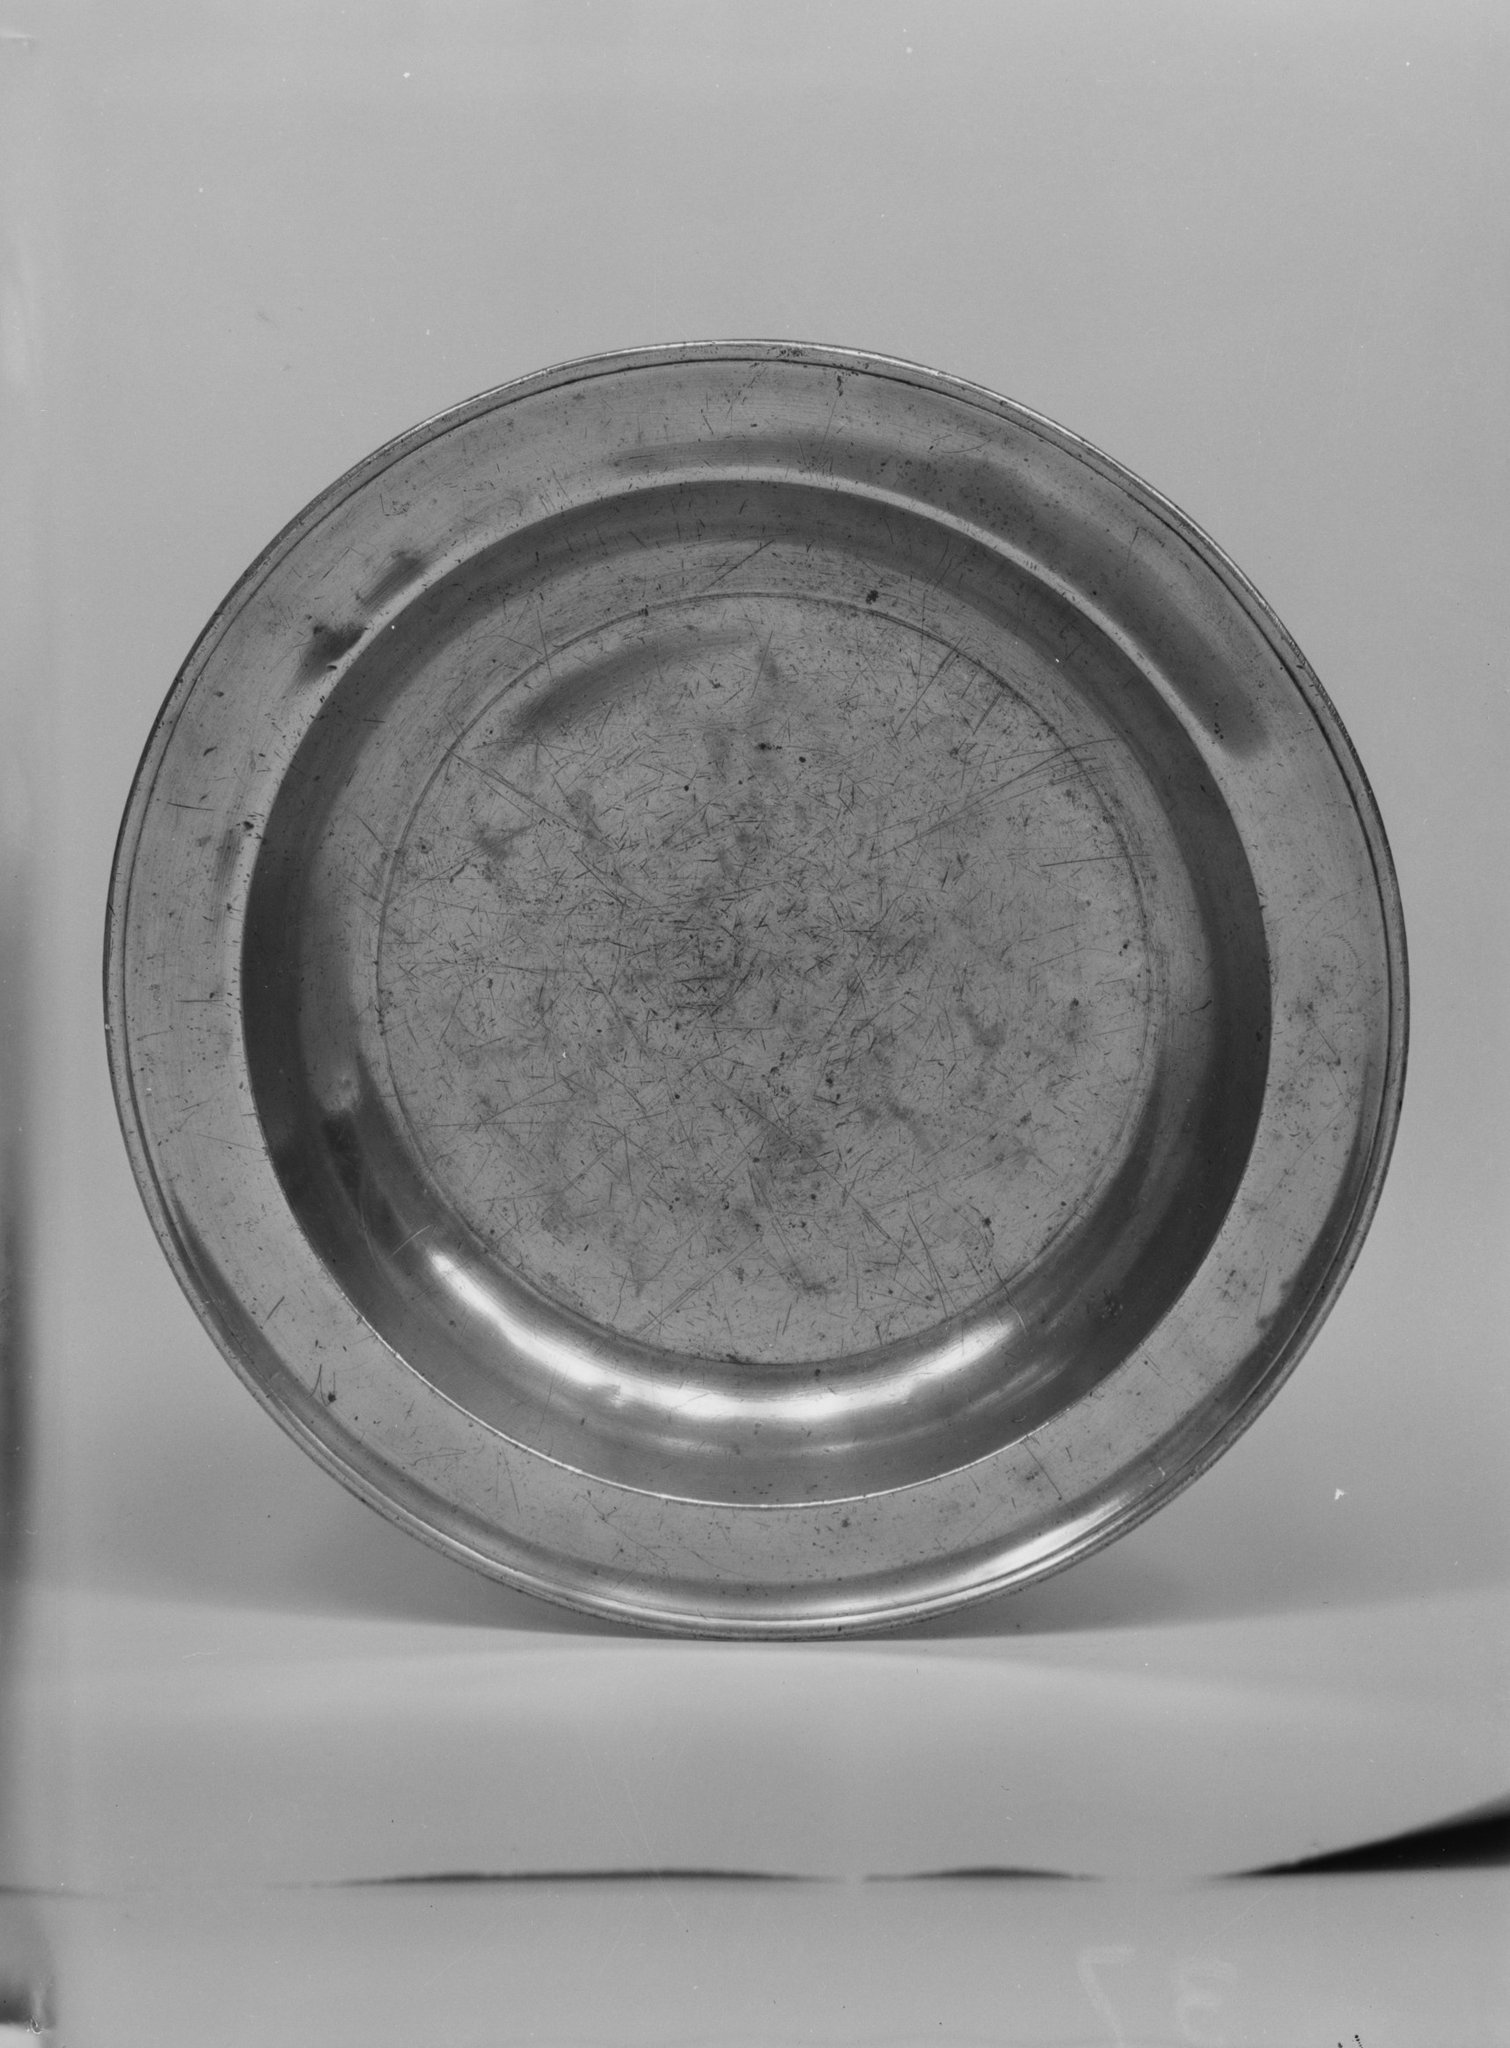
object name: dish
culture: american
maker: samuel kilbourn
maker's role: maker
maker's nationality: american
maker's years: 1793-1839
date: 1814-1839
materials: pewter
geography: united states